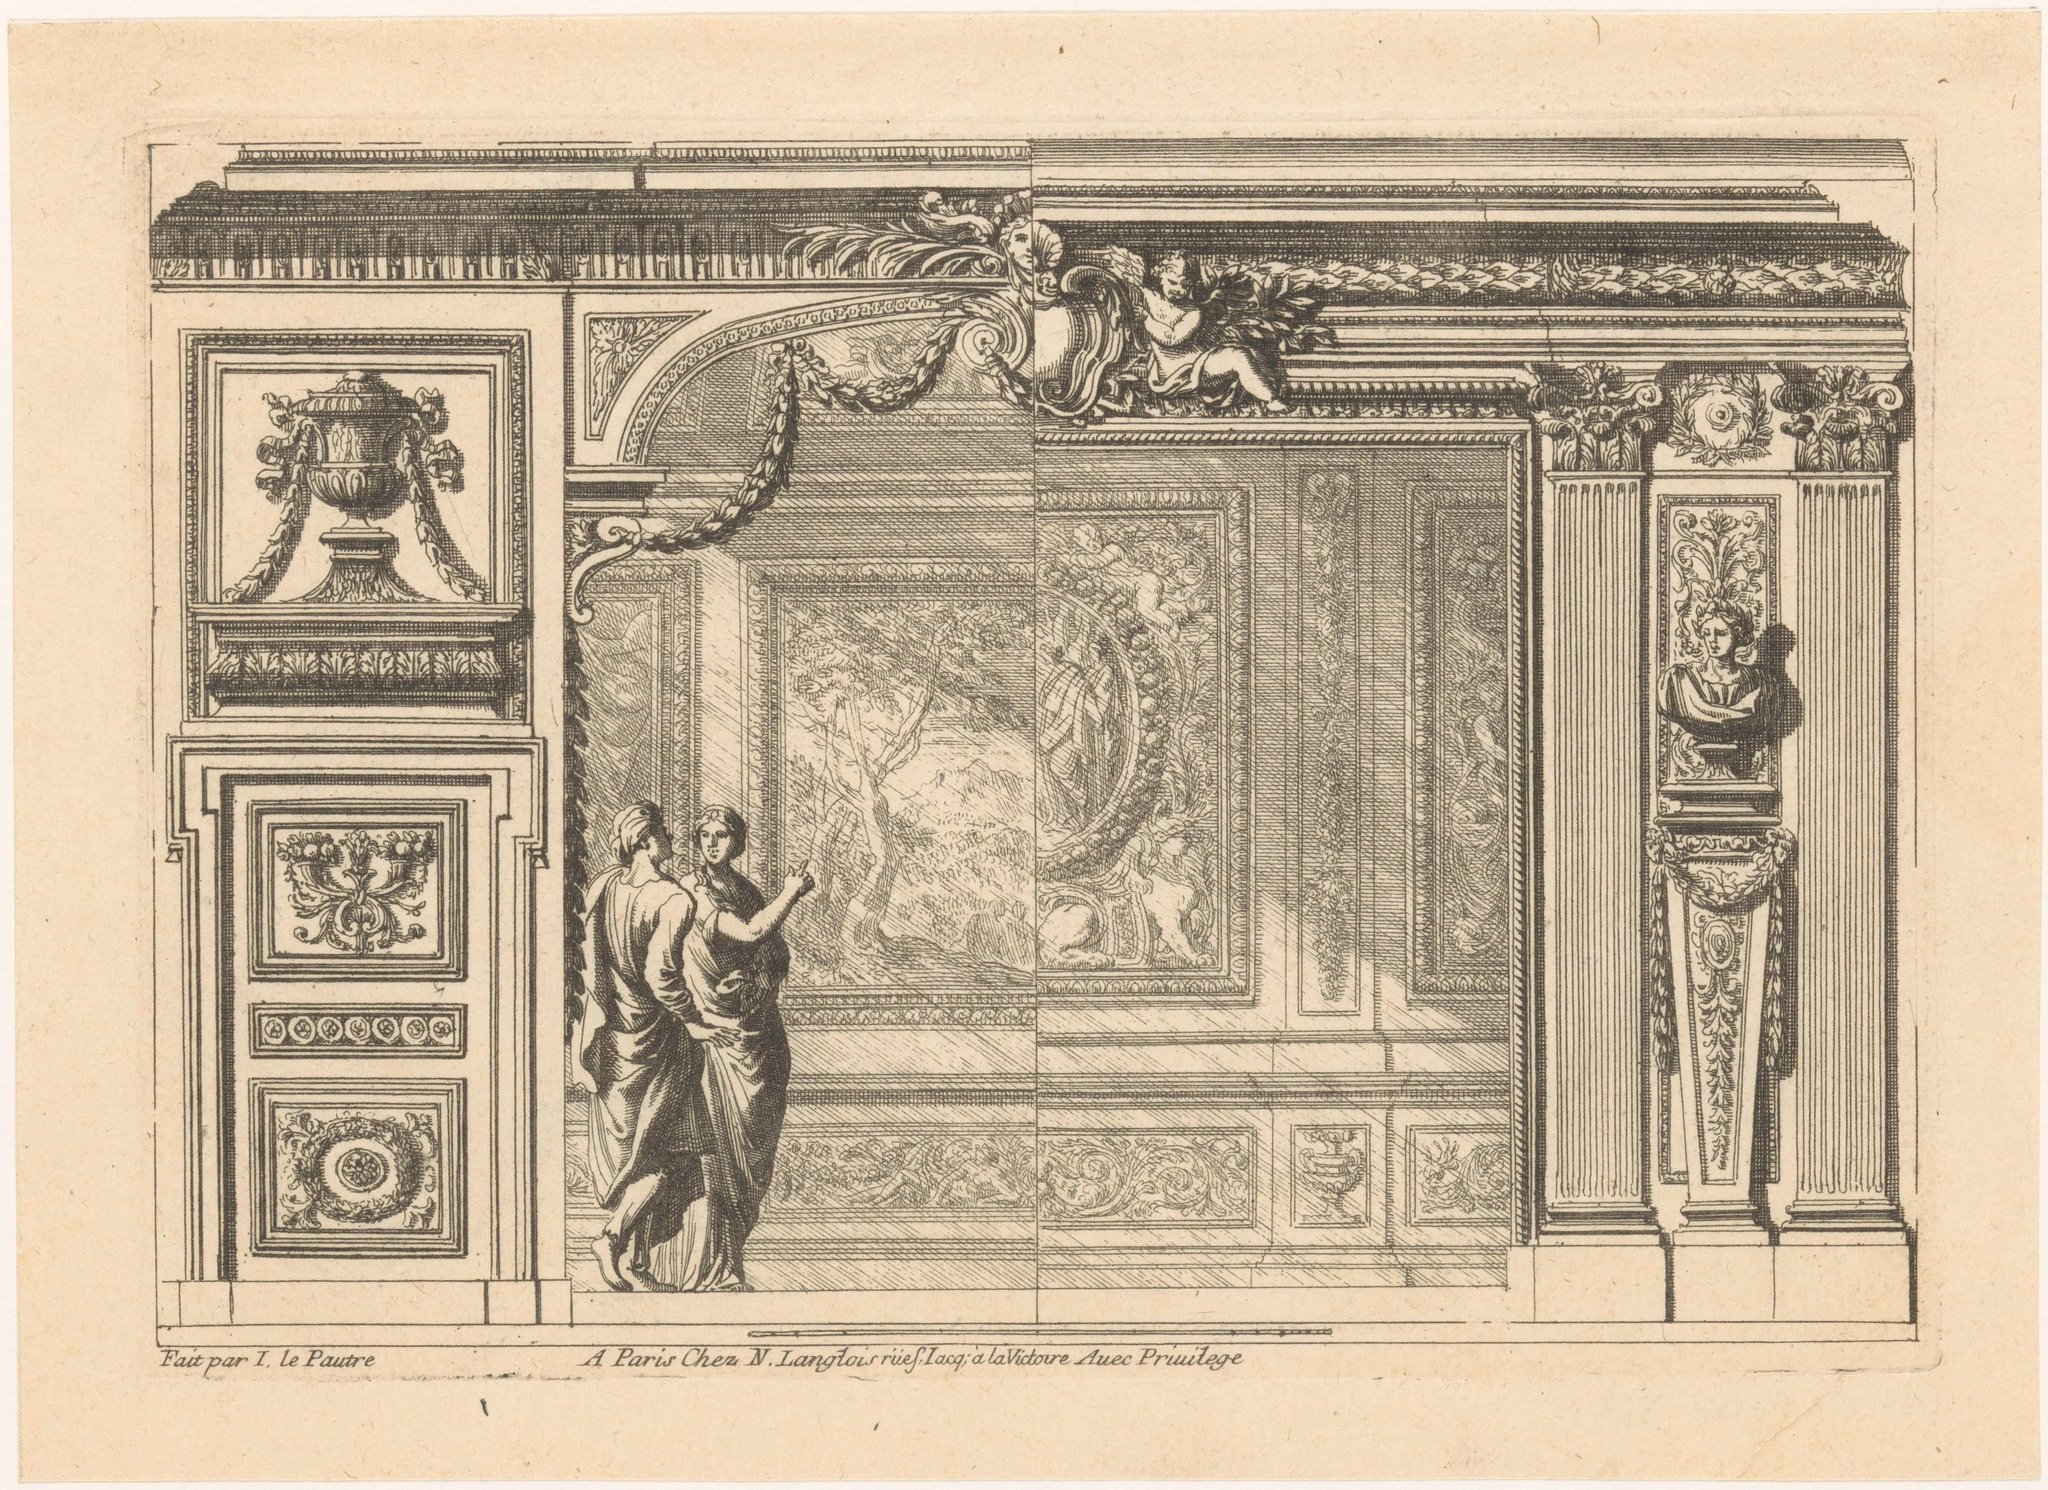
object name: print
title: Alcoves à la Francoise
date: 1678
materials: paper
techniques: etching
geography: paris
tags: interior of the house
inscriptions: collector's mark: Lugt 2228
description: Aan de linkerkant een deur met dessus-de-porte met een vaas. Rechts een muur met twee Korintische pilasters met daartussen een keizersbuste.